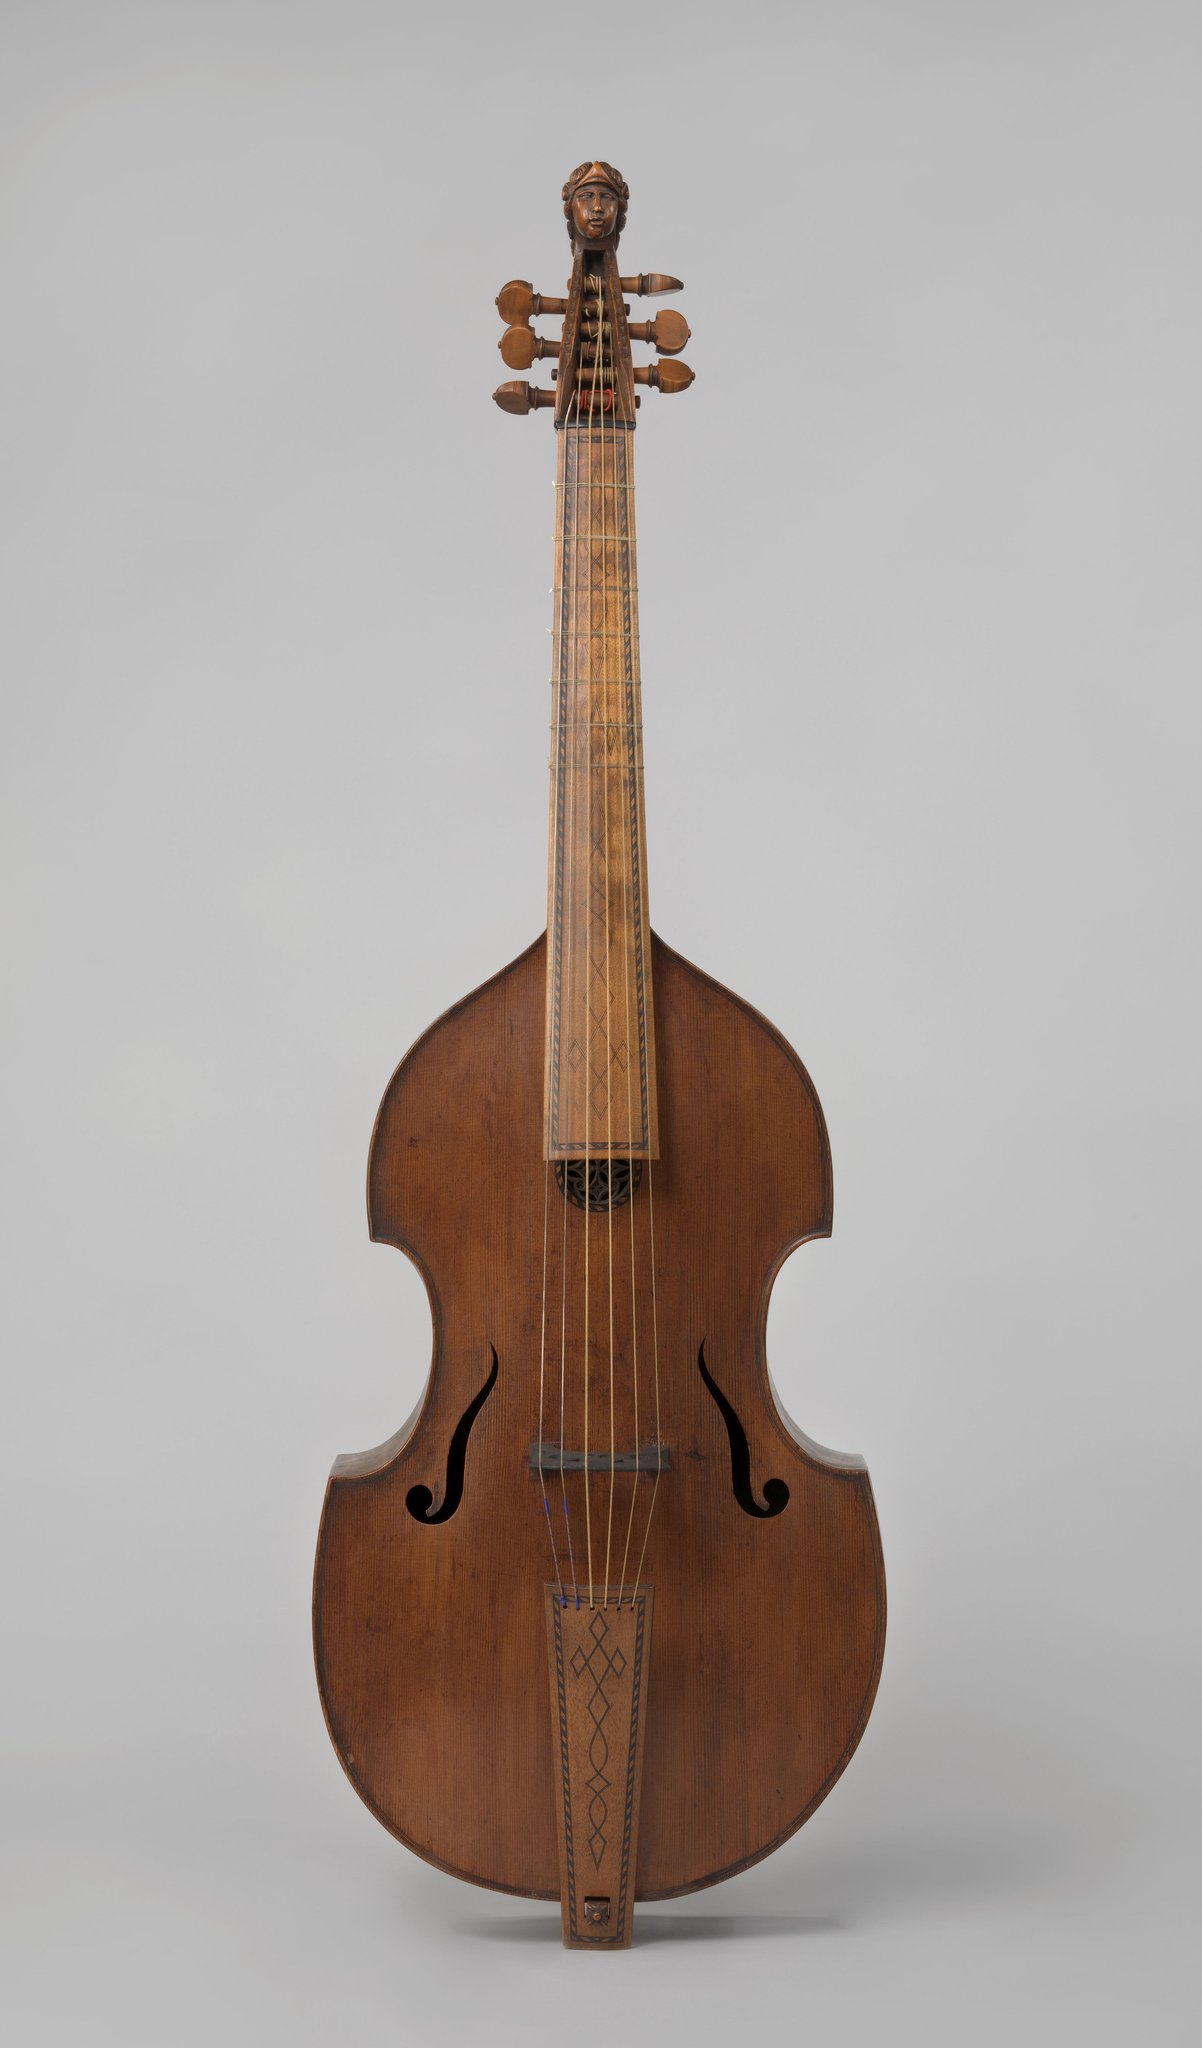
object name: viola da gamba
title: Bass viol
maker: hendrik jacobs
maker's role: musical instrument maker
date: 1680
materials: intestine, wood, silver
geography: amsterdam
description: The bass viol was used as a solo instrument or to provide the bass line in chamber music ensembles. Its six strings are played with a bow held underhand. This instrument was made by Hendrik Jacobs, one of the most important 17th-century Dutch violin makers. The Italian term viola da gamba denotes that these instruments were played while resting on the leg.